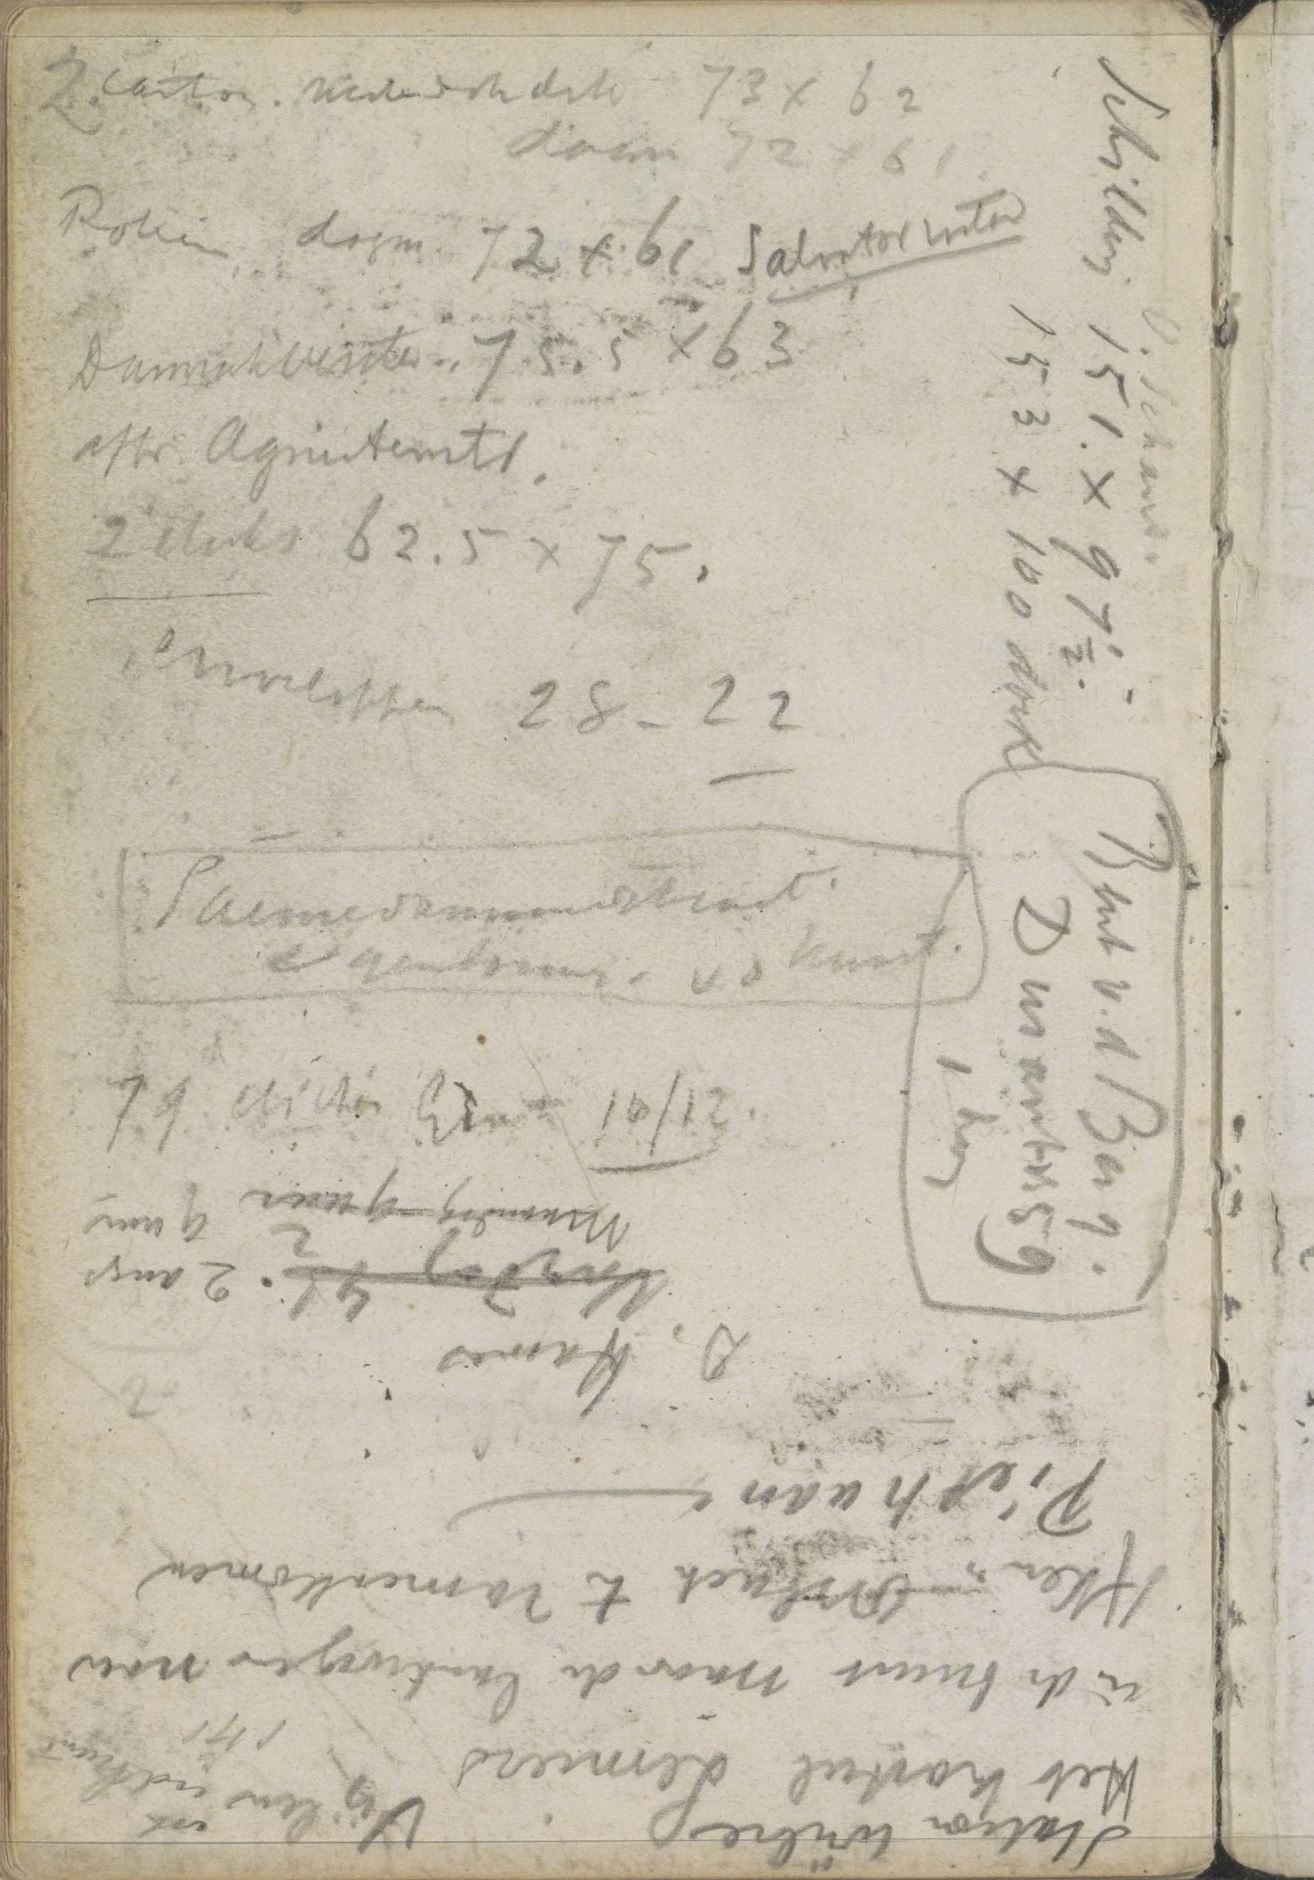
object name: sketchbook leaf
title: Annotaties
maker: george hendrik breitner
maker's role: draughtsman, painter, print maker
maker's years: 1857-1923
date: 1886-1908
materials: paper, pencil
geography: amsterdam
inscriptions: size, annotation: ‘Station Wülre [Wijlre]/ Vijlen/ Het kasteel Lemiers/ in de buurt waar de landwegen naar/ Aken en Orsbach te samenkomen/ Piethaane’, annotation: ‘Bent v.d. Berg./ Dusantstr 59/ 1 hoog’, annotation: ‘D. Ham[...]/ 2 augs/ 9 uur’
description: Pagina 93 uit een schetsboek met 46 bladen vervaardigd te Amsterdam, Haarlem en Antwerpen.